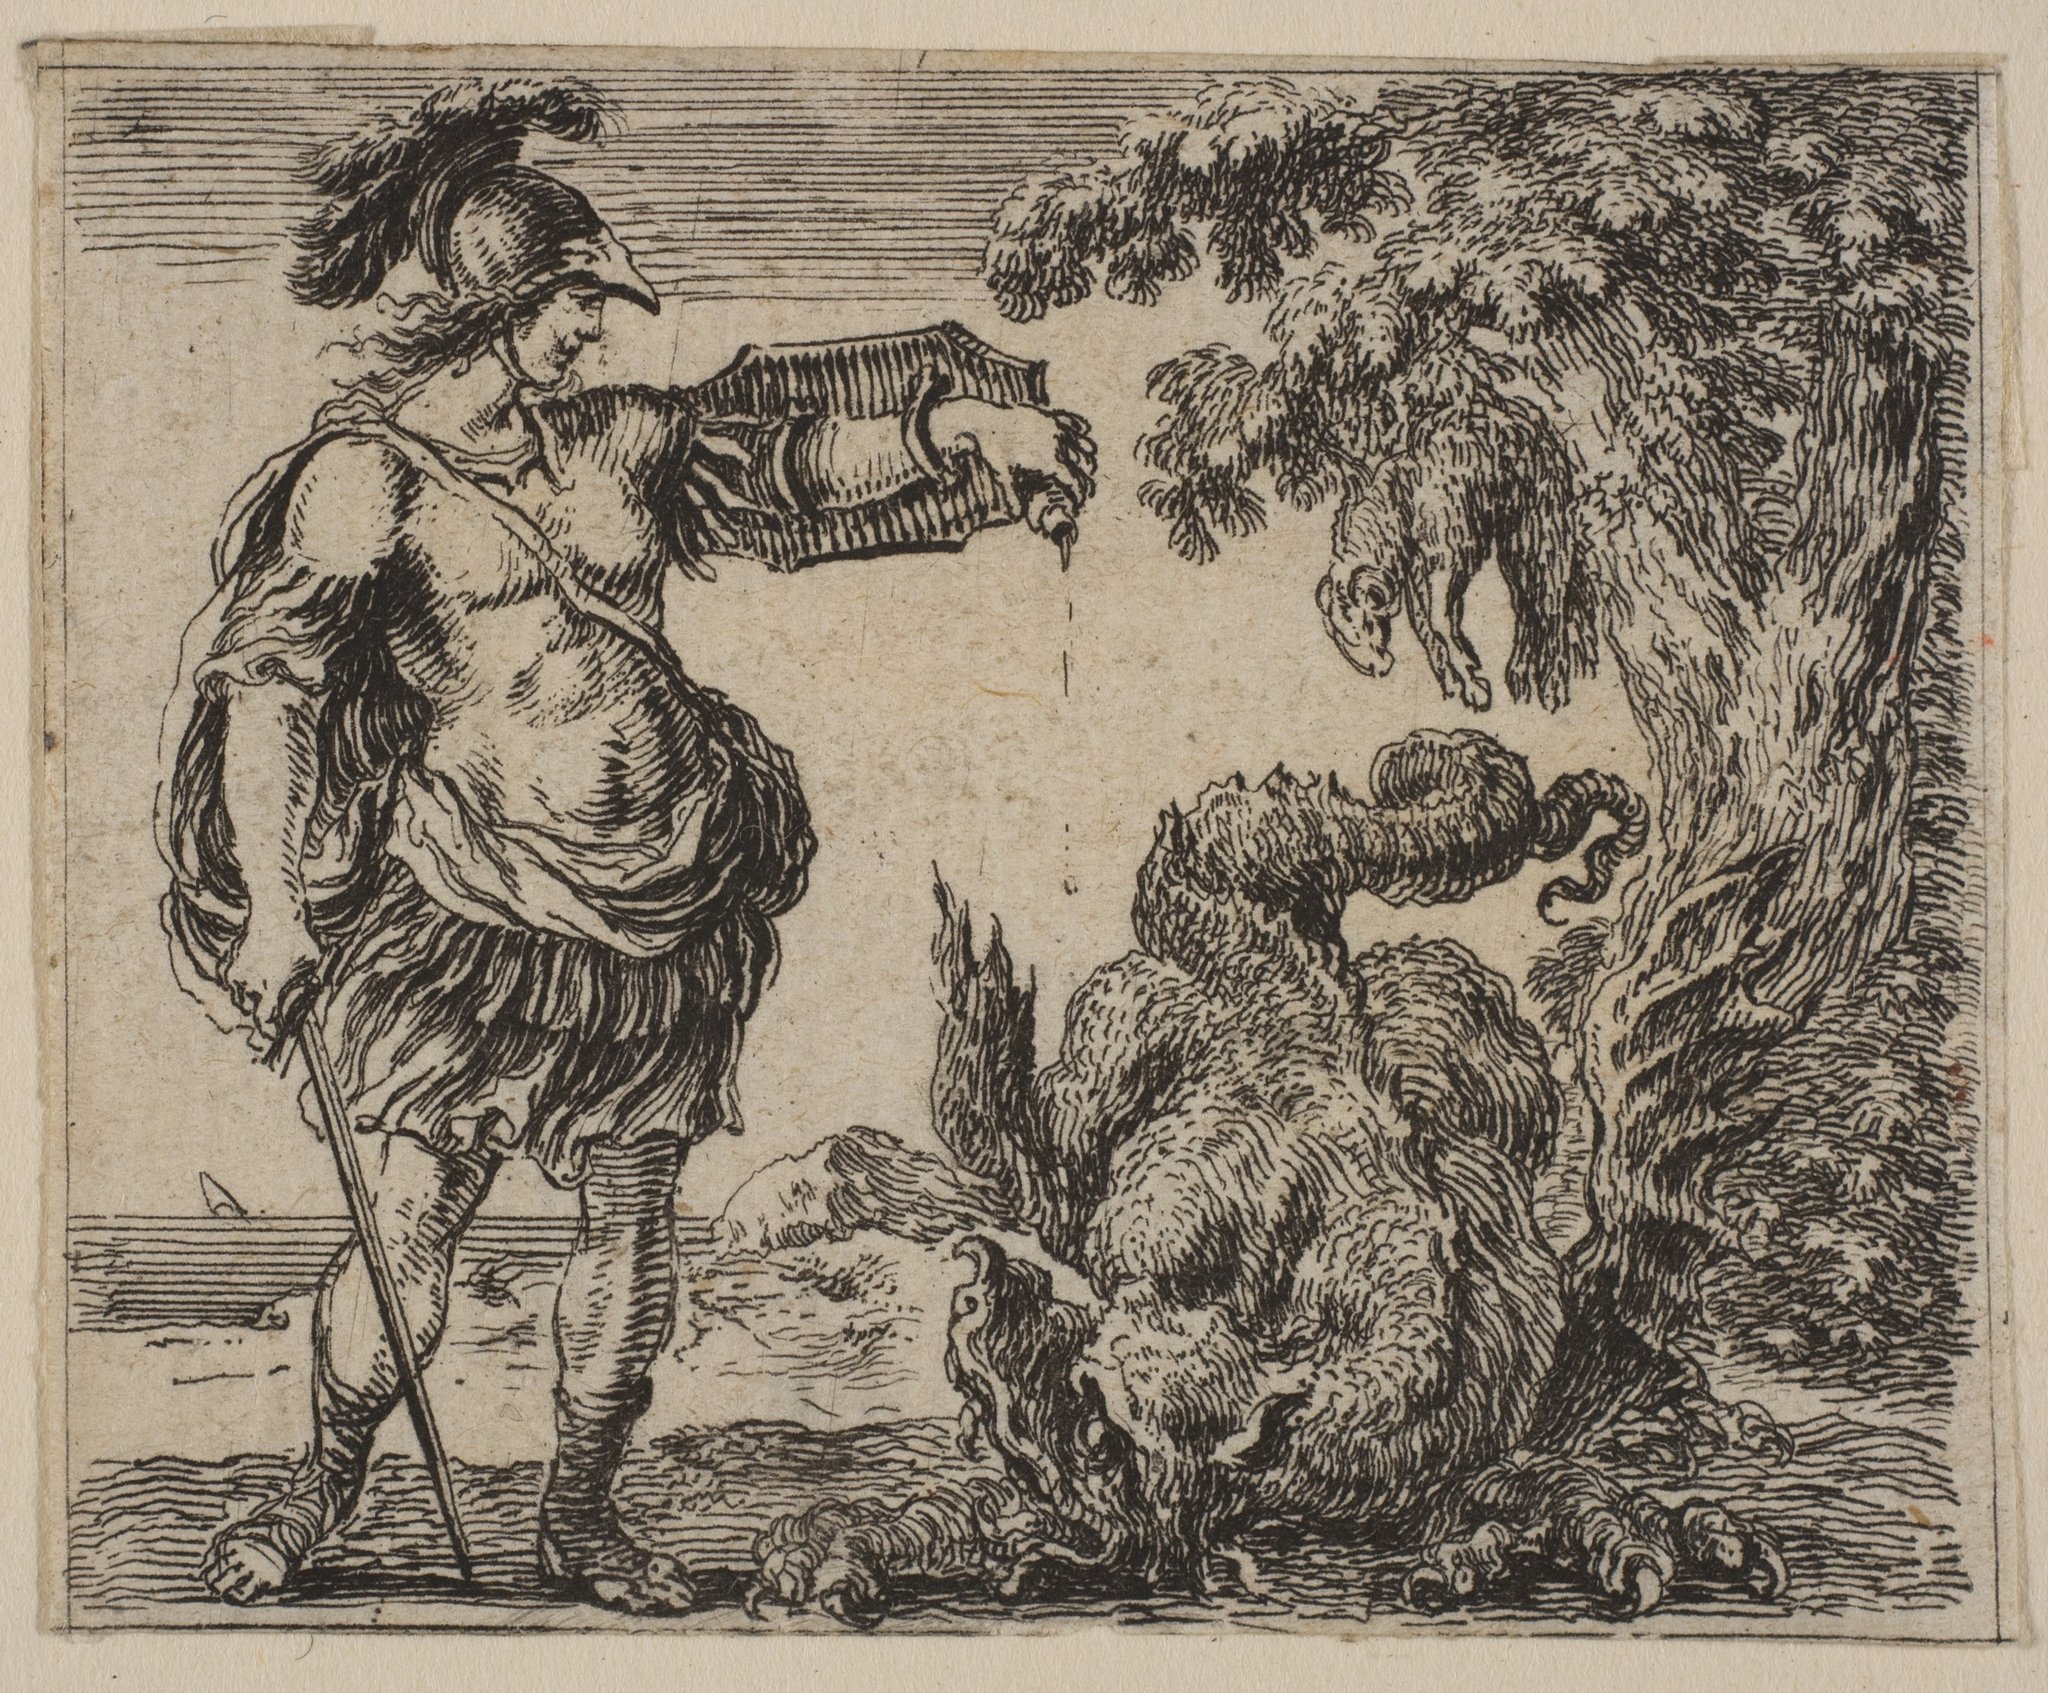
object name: print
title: Jason, from 'Game of Mythology' (Jeu de la Mythologie)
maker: stefano della bella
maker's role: artist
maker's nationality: italian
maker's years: 1610-1664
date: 1644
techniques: etching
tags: shields,swords,jason,dragons,trees